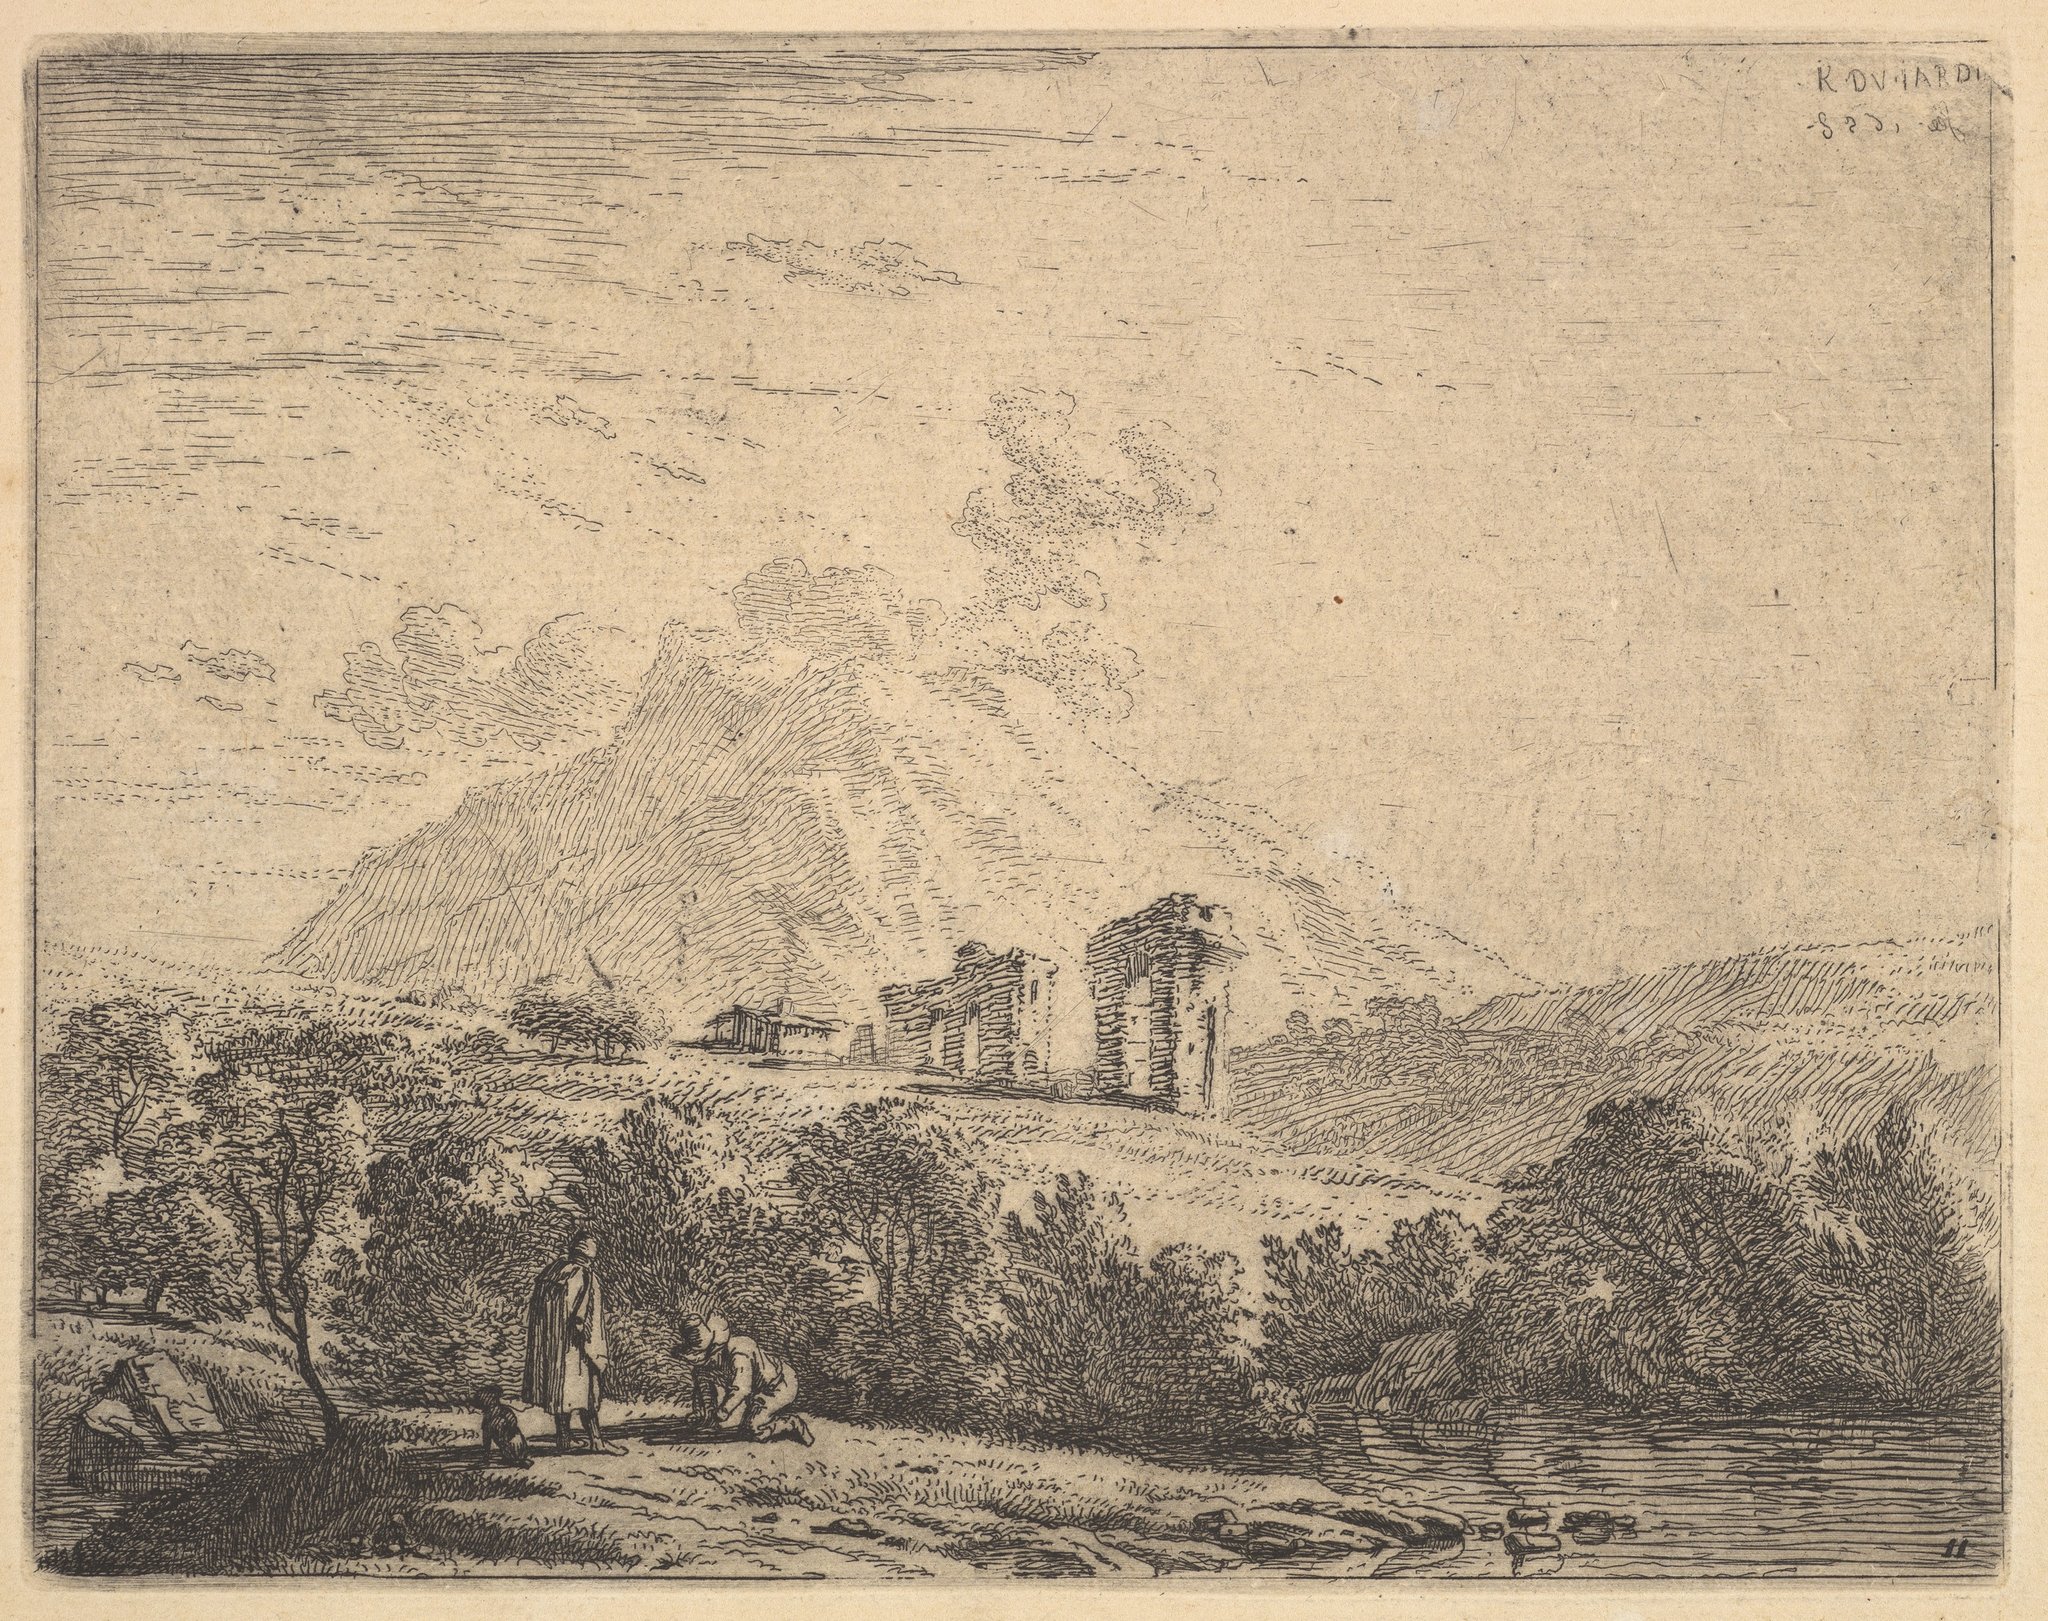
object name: print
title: View of hillside with ruins (an aqueduct?) and mountain crag beyond, in the foreground a man kneels on the grass beside a standing man and a dog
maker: karel dujardin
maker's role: artist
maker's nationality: dutch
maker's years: 1622-1678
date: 1658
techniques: etching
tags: ruins,men,hills,landscapes